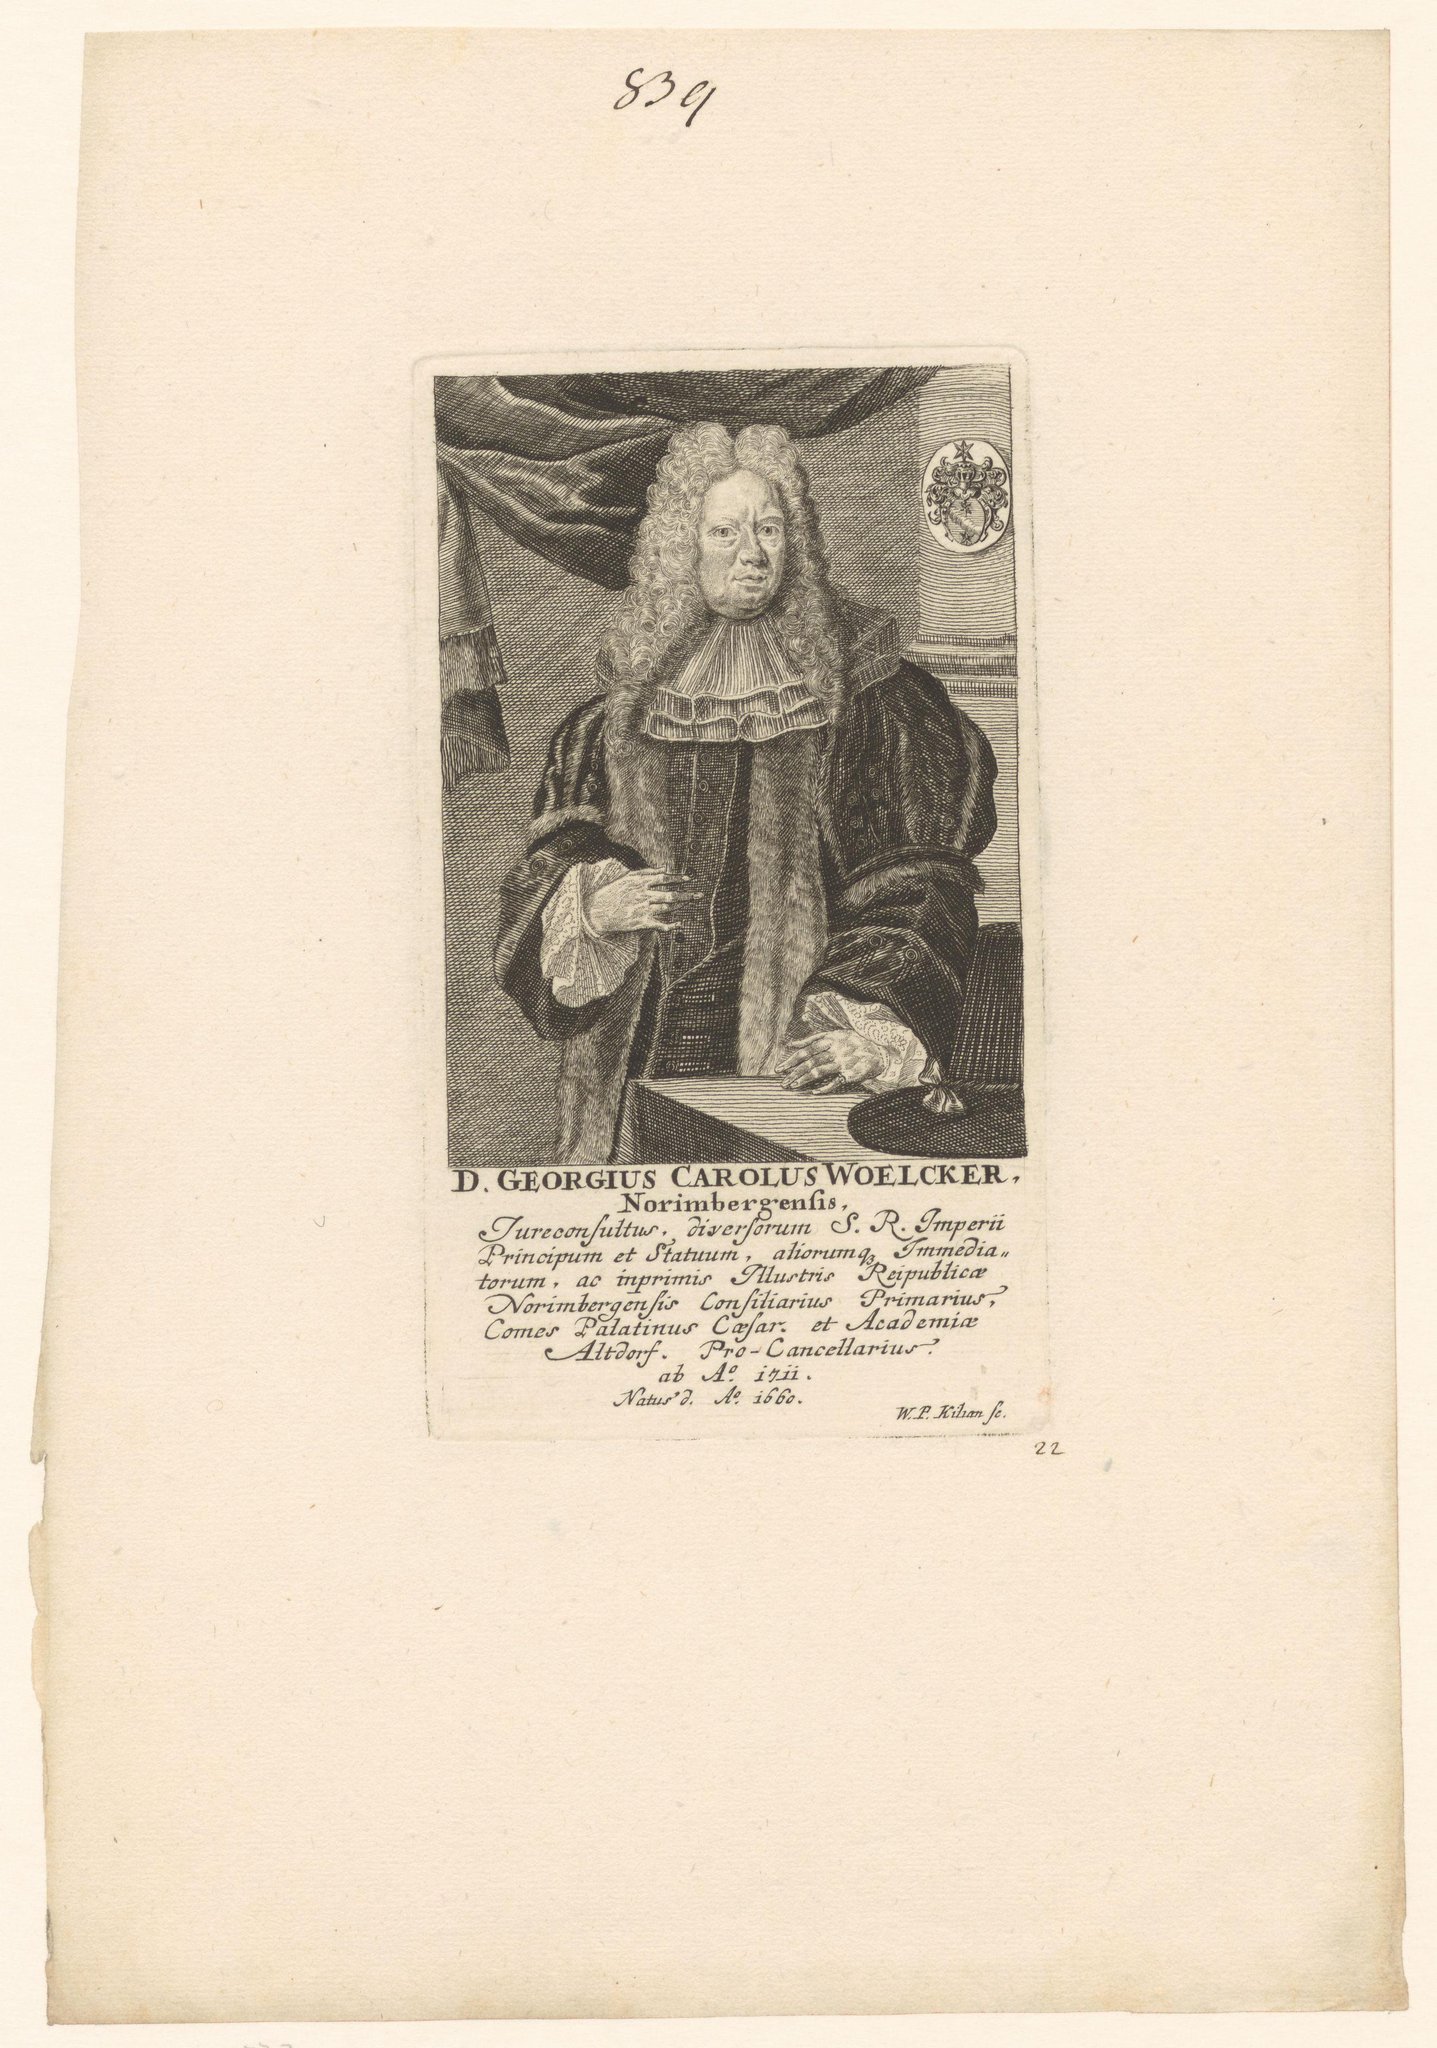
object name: print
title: Portret van Georg Carl Woelcker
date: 1711-1721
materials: paper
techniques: engraving, etching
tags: historical persons, lawyer, attorney at law, counsellor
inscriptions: collector's mark: Lugt 2228, number: ‘22’